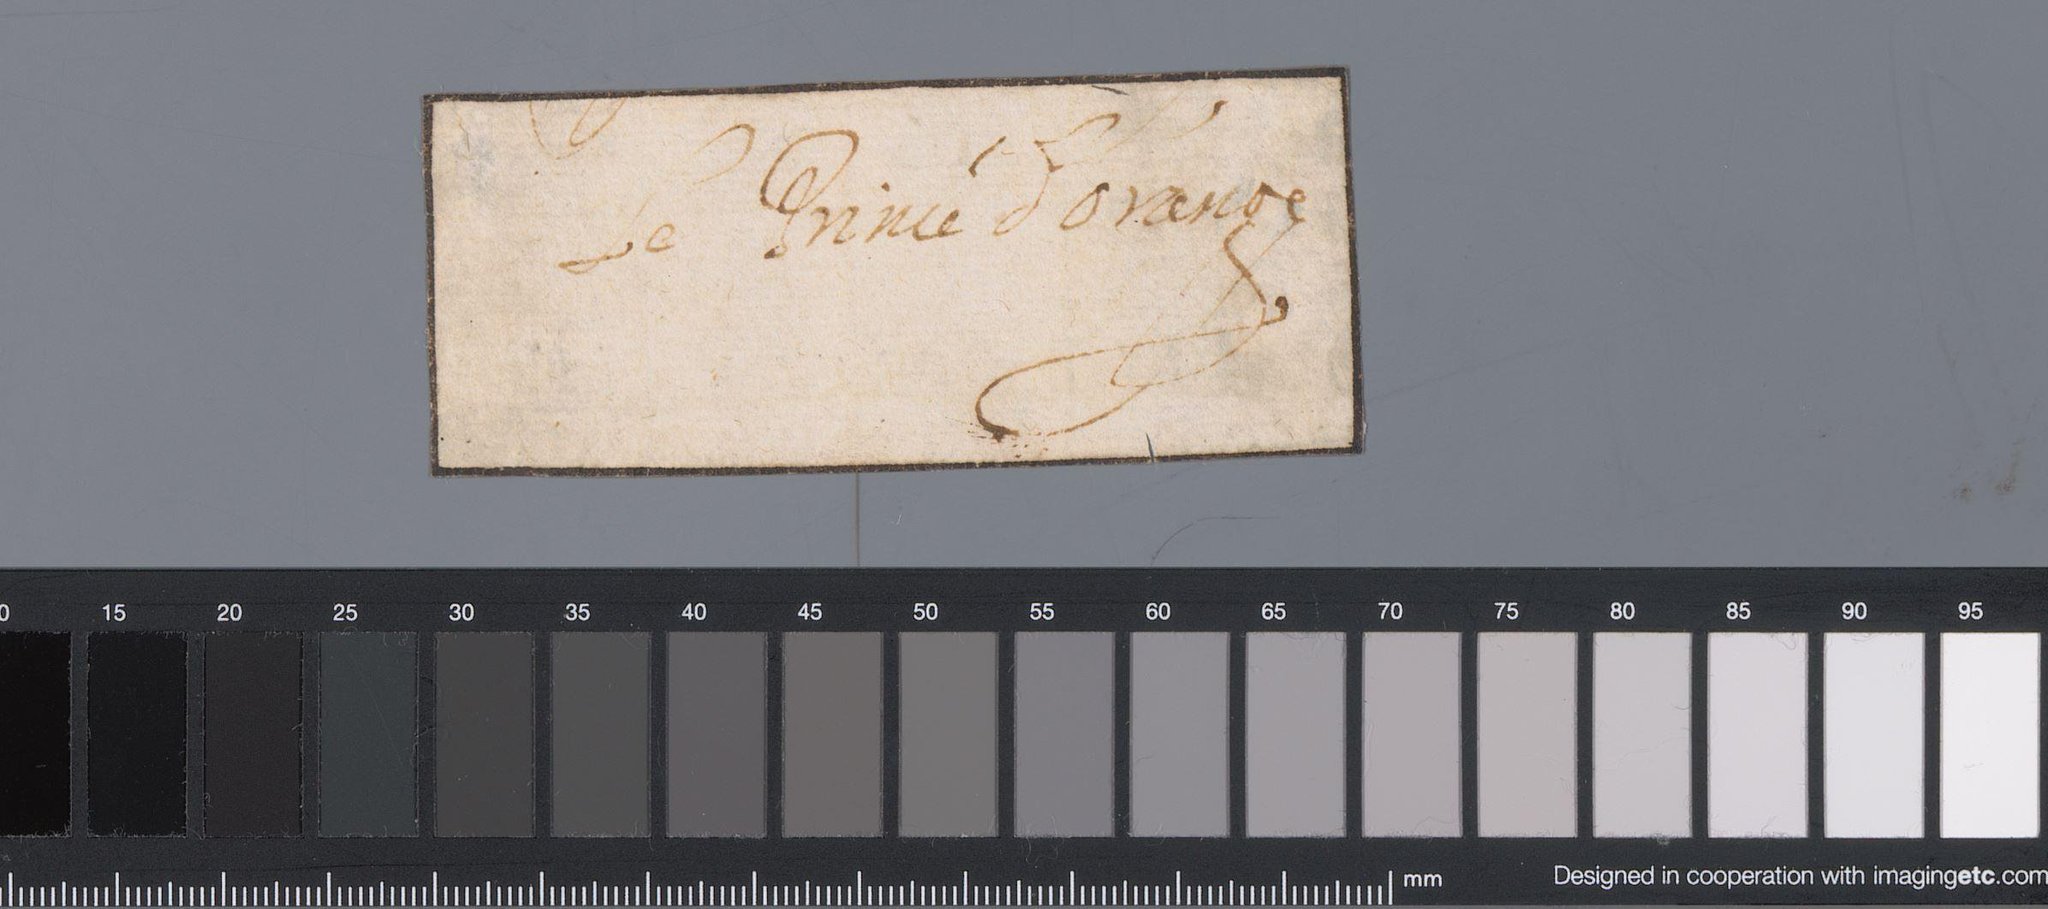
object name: sheet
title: Document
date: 1575-1624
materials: ink, paper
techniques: writing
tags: the hague, maurice (prince of orange), buren, bruges, filips willem (prins van oranje)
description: Handtekening in bruine inkt (van Filips Willem of van Maurits), op uitgeknipt blaadje papier. Gesigneerd: Le Prince d'orange.